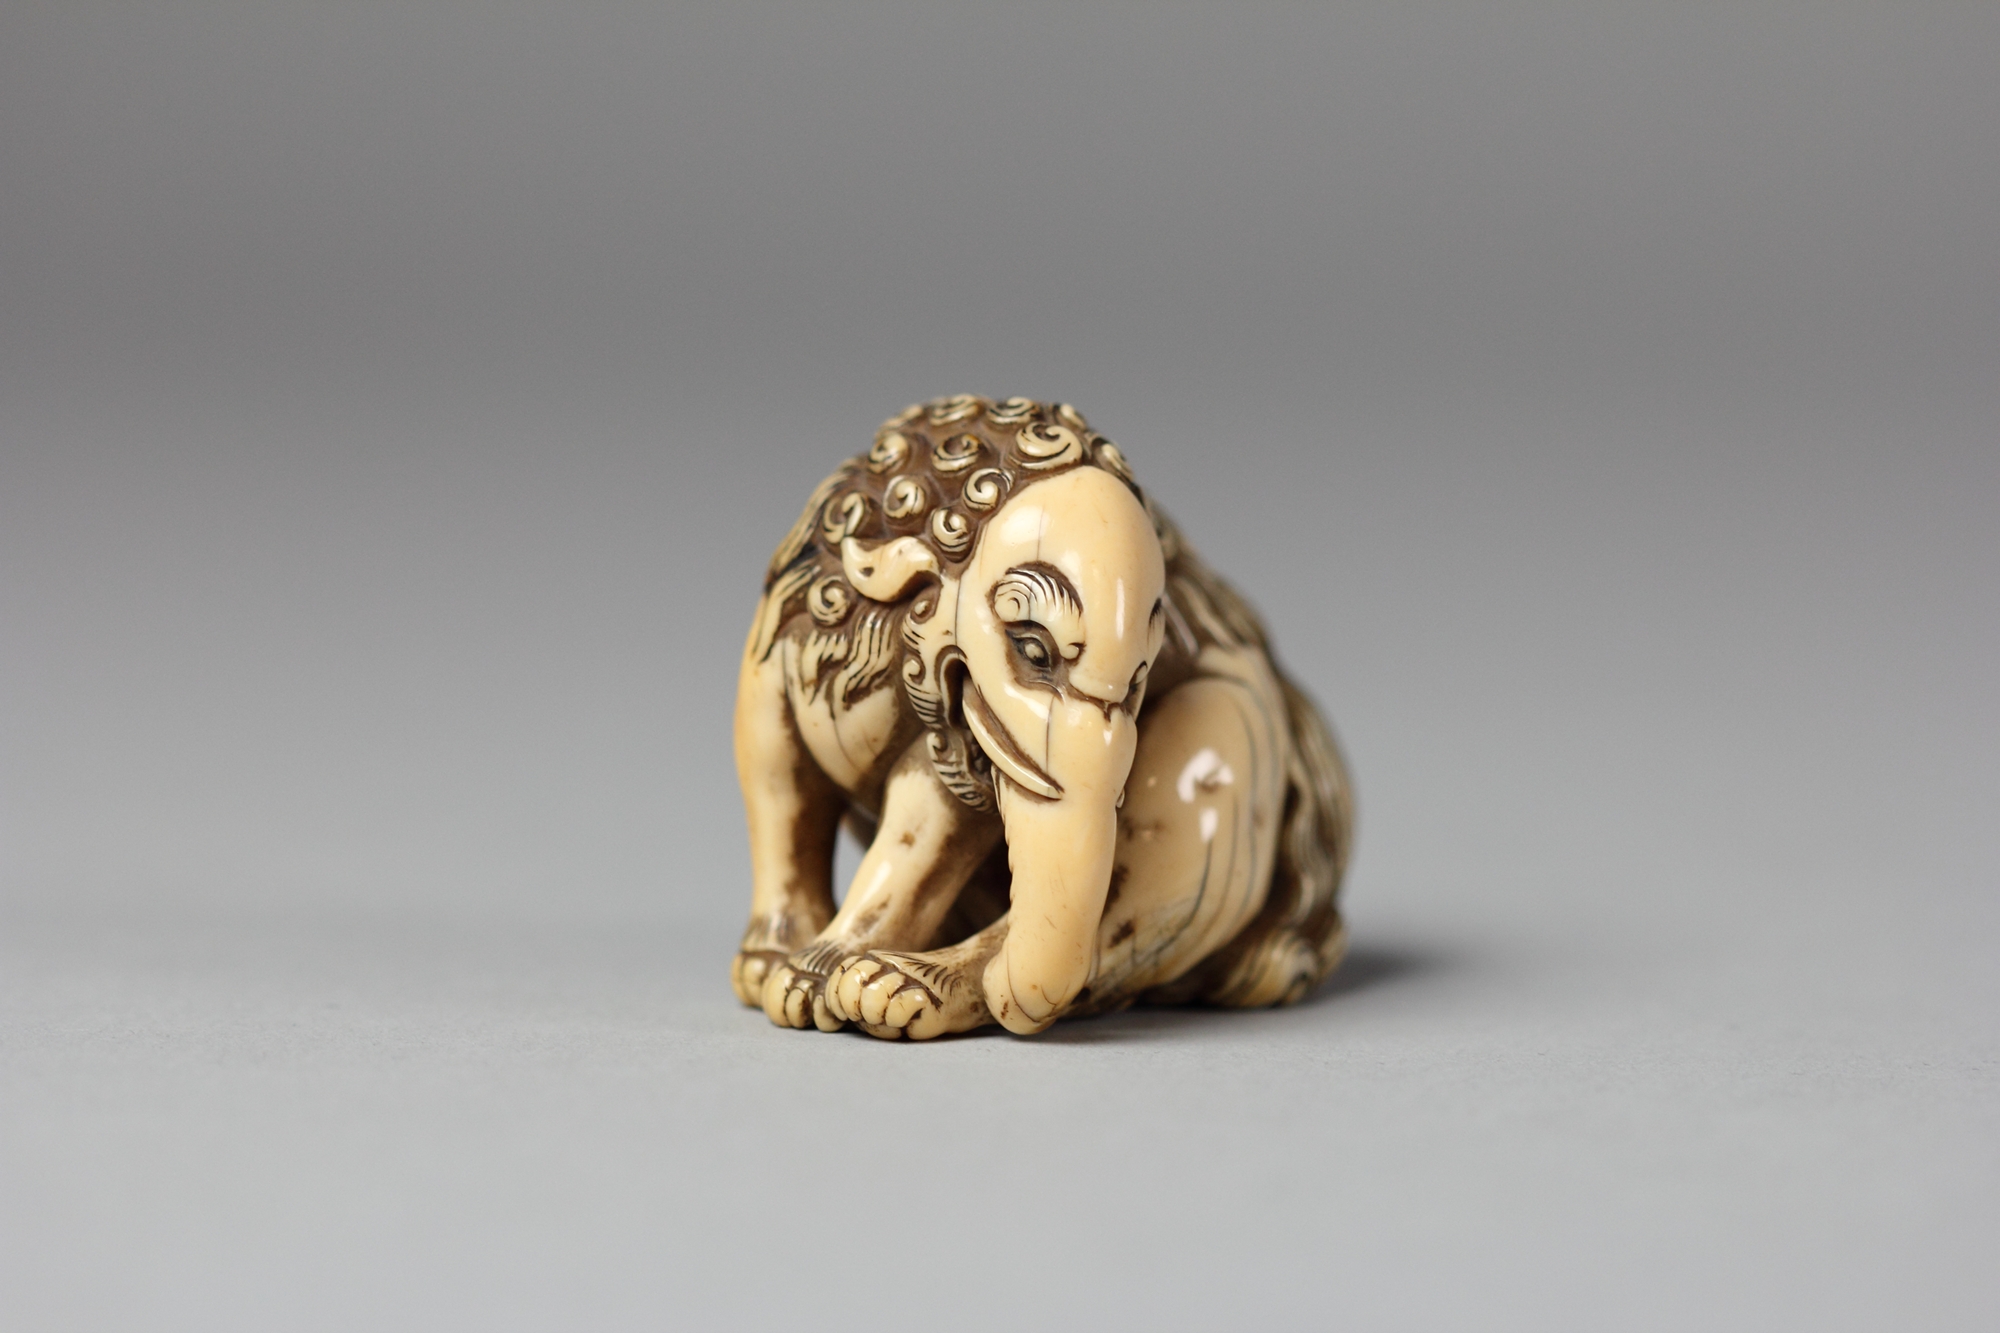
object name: netsuke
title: Netsuke of Seated Baku (mythical animal)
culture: japanese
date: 1801-1900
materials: ivory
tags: mythical creatures